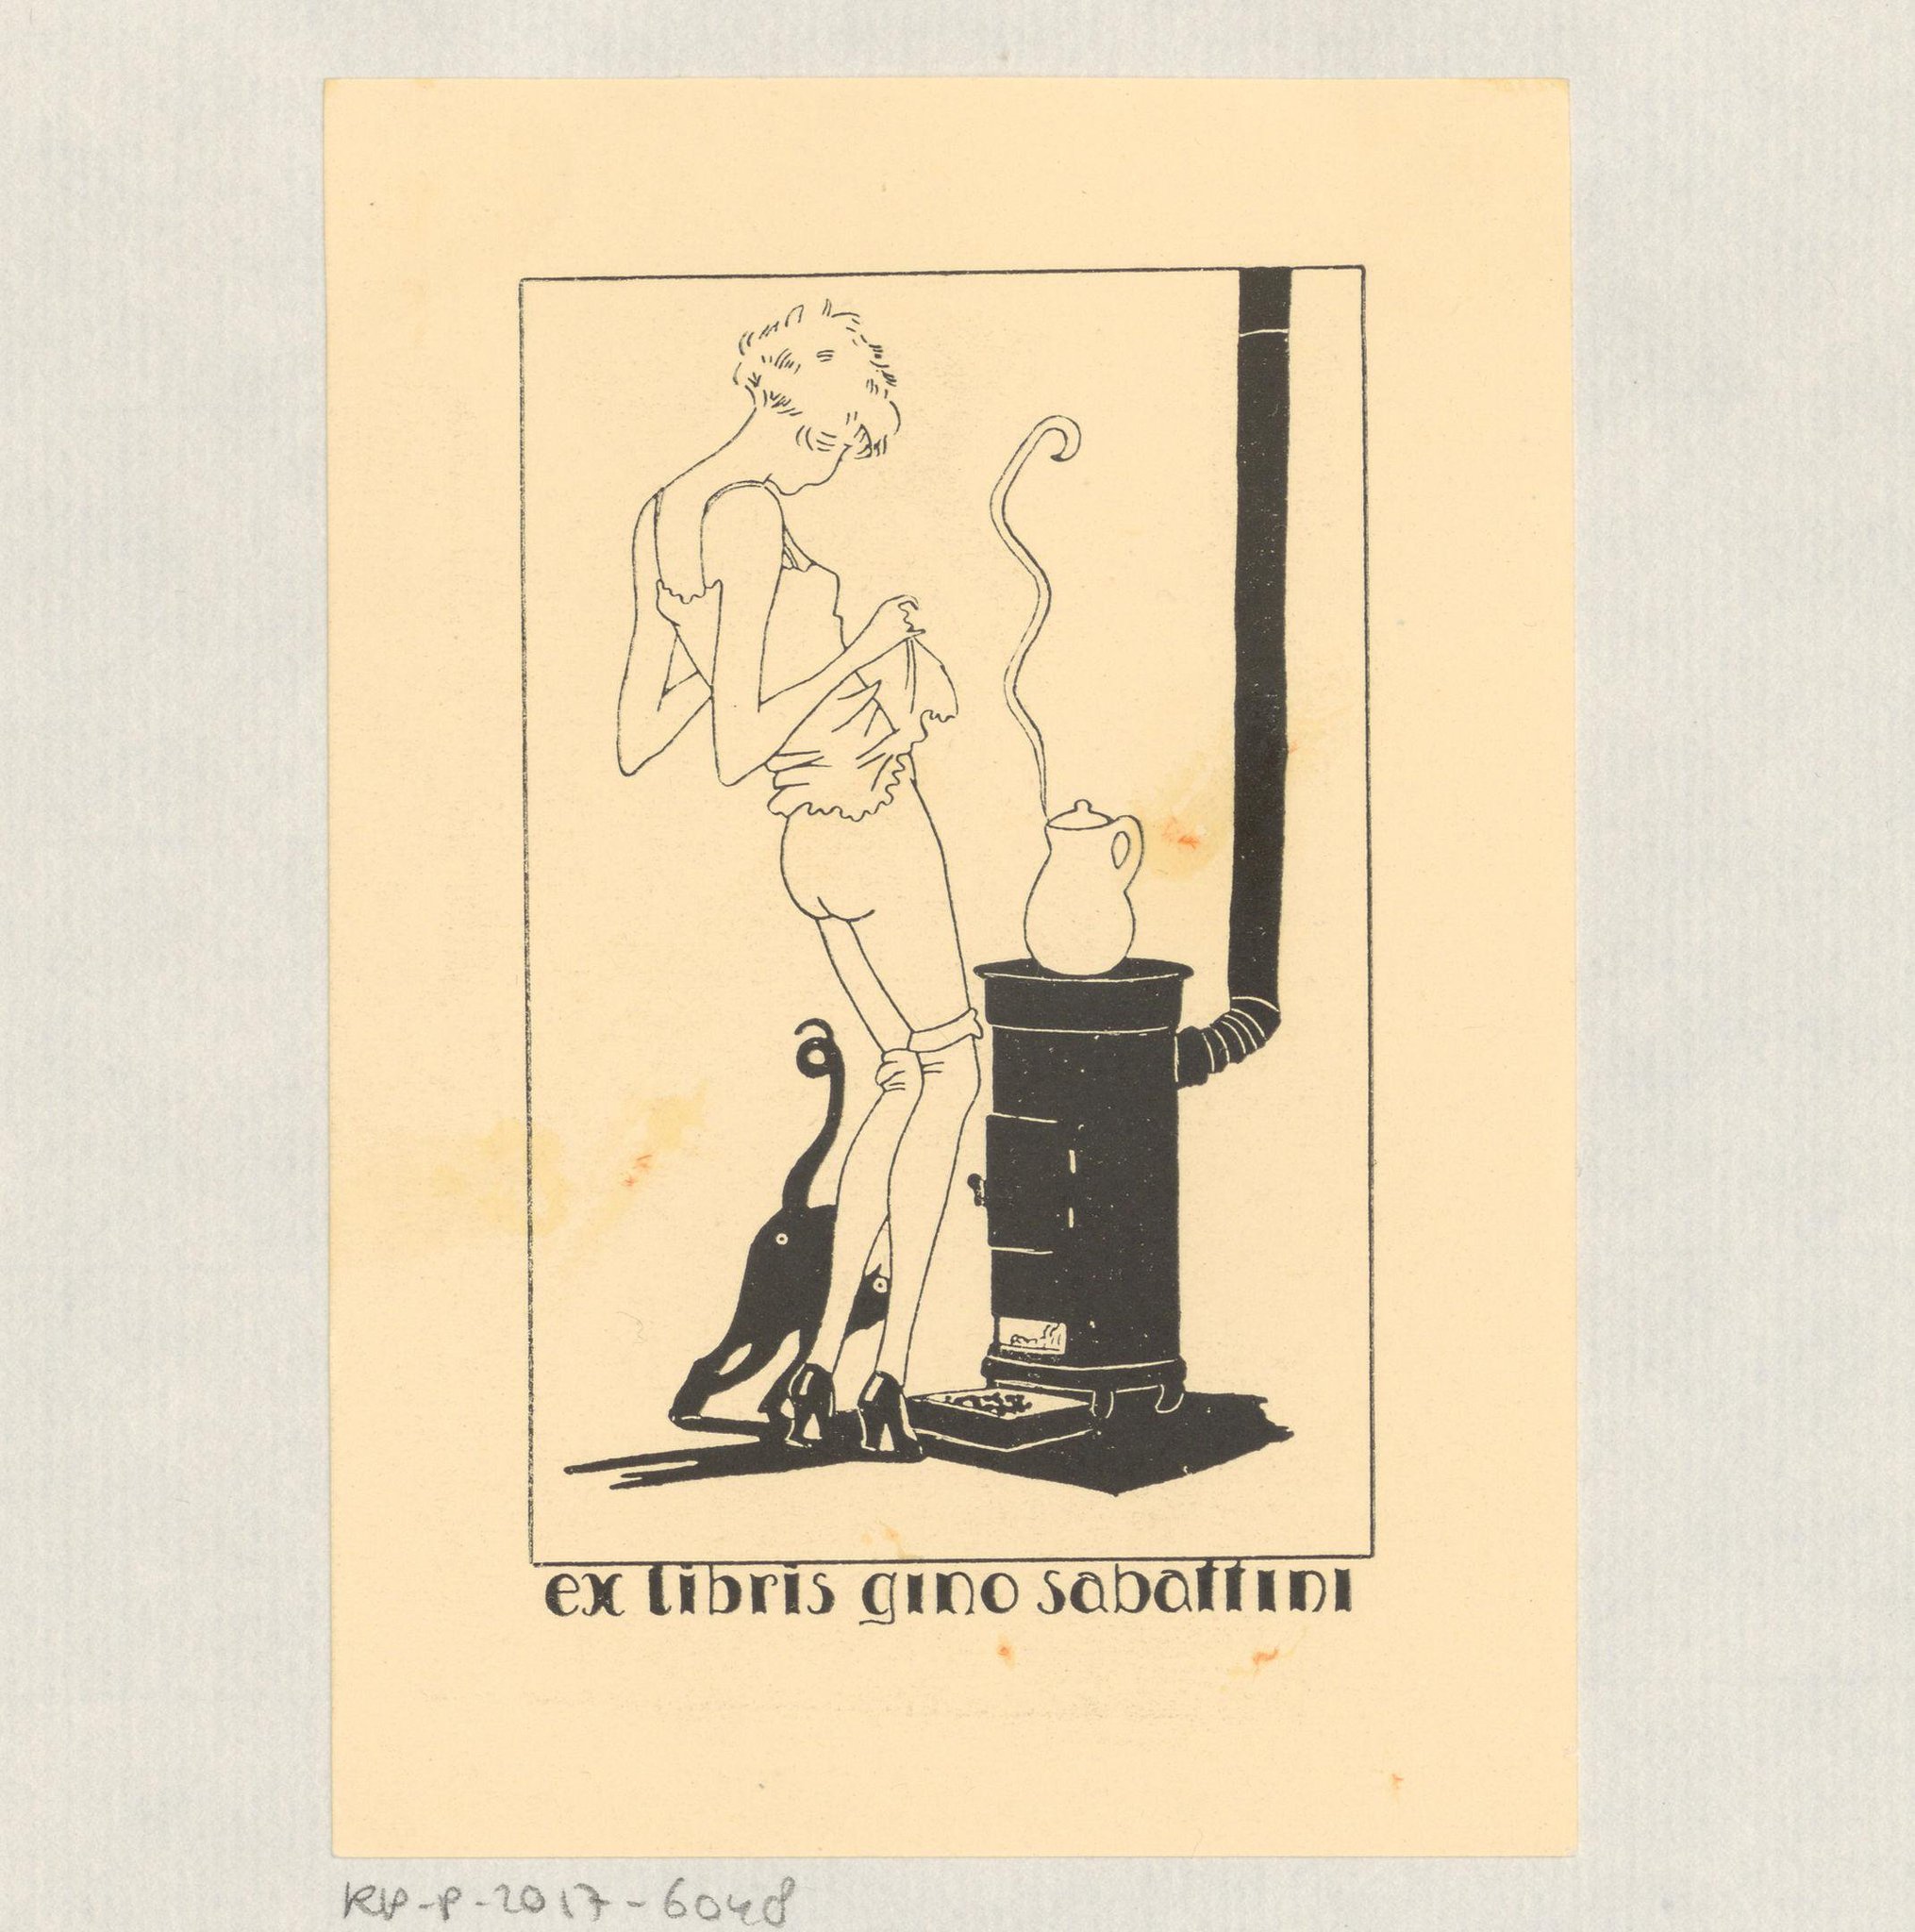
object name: bookplate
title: Ex libris van Gino Sabattini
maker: Anonymous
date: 1945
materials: paper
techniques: printing block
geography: spain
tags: gino sabattini, cat, woman (showing herself) undressed, quasi-nude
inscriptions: inscription: ‘Fournier’